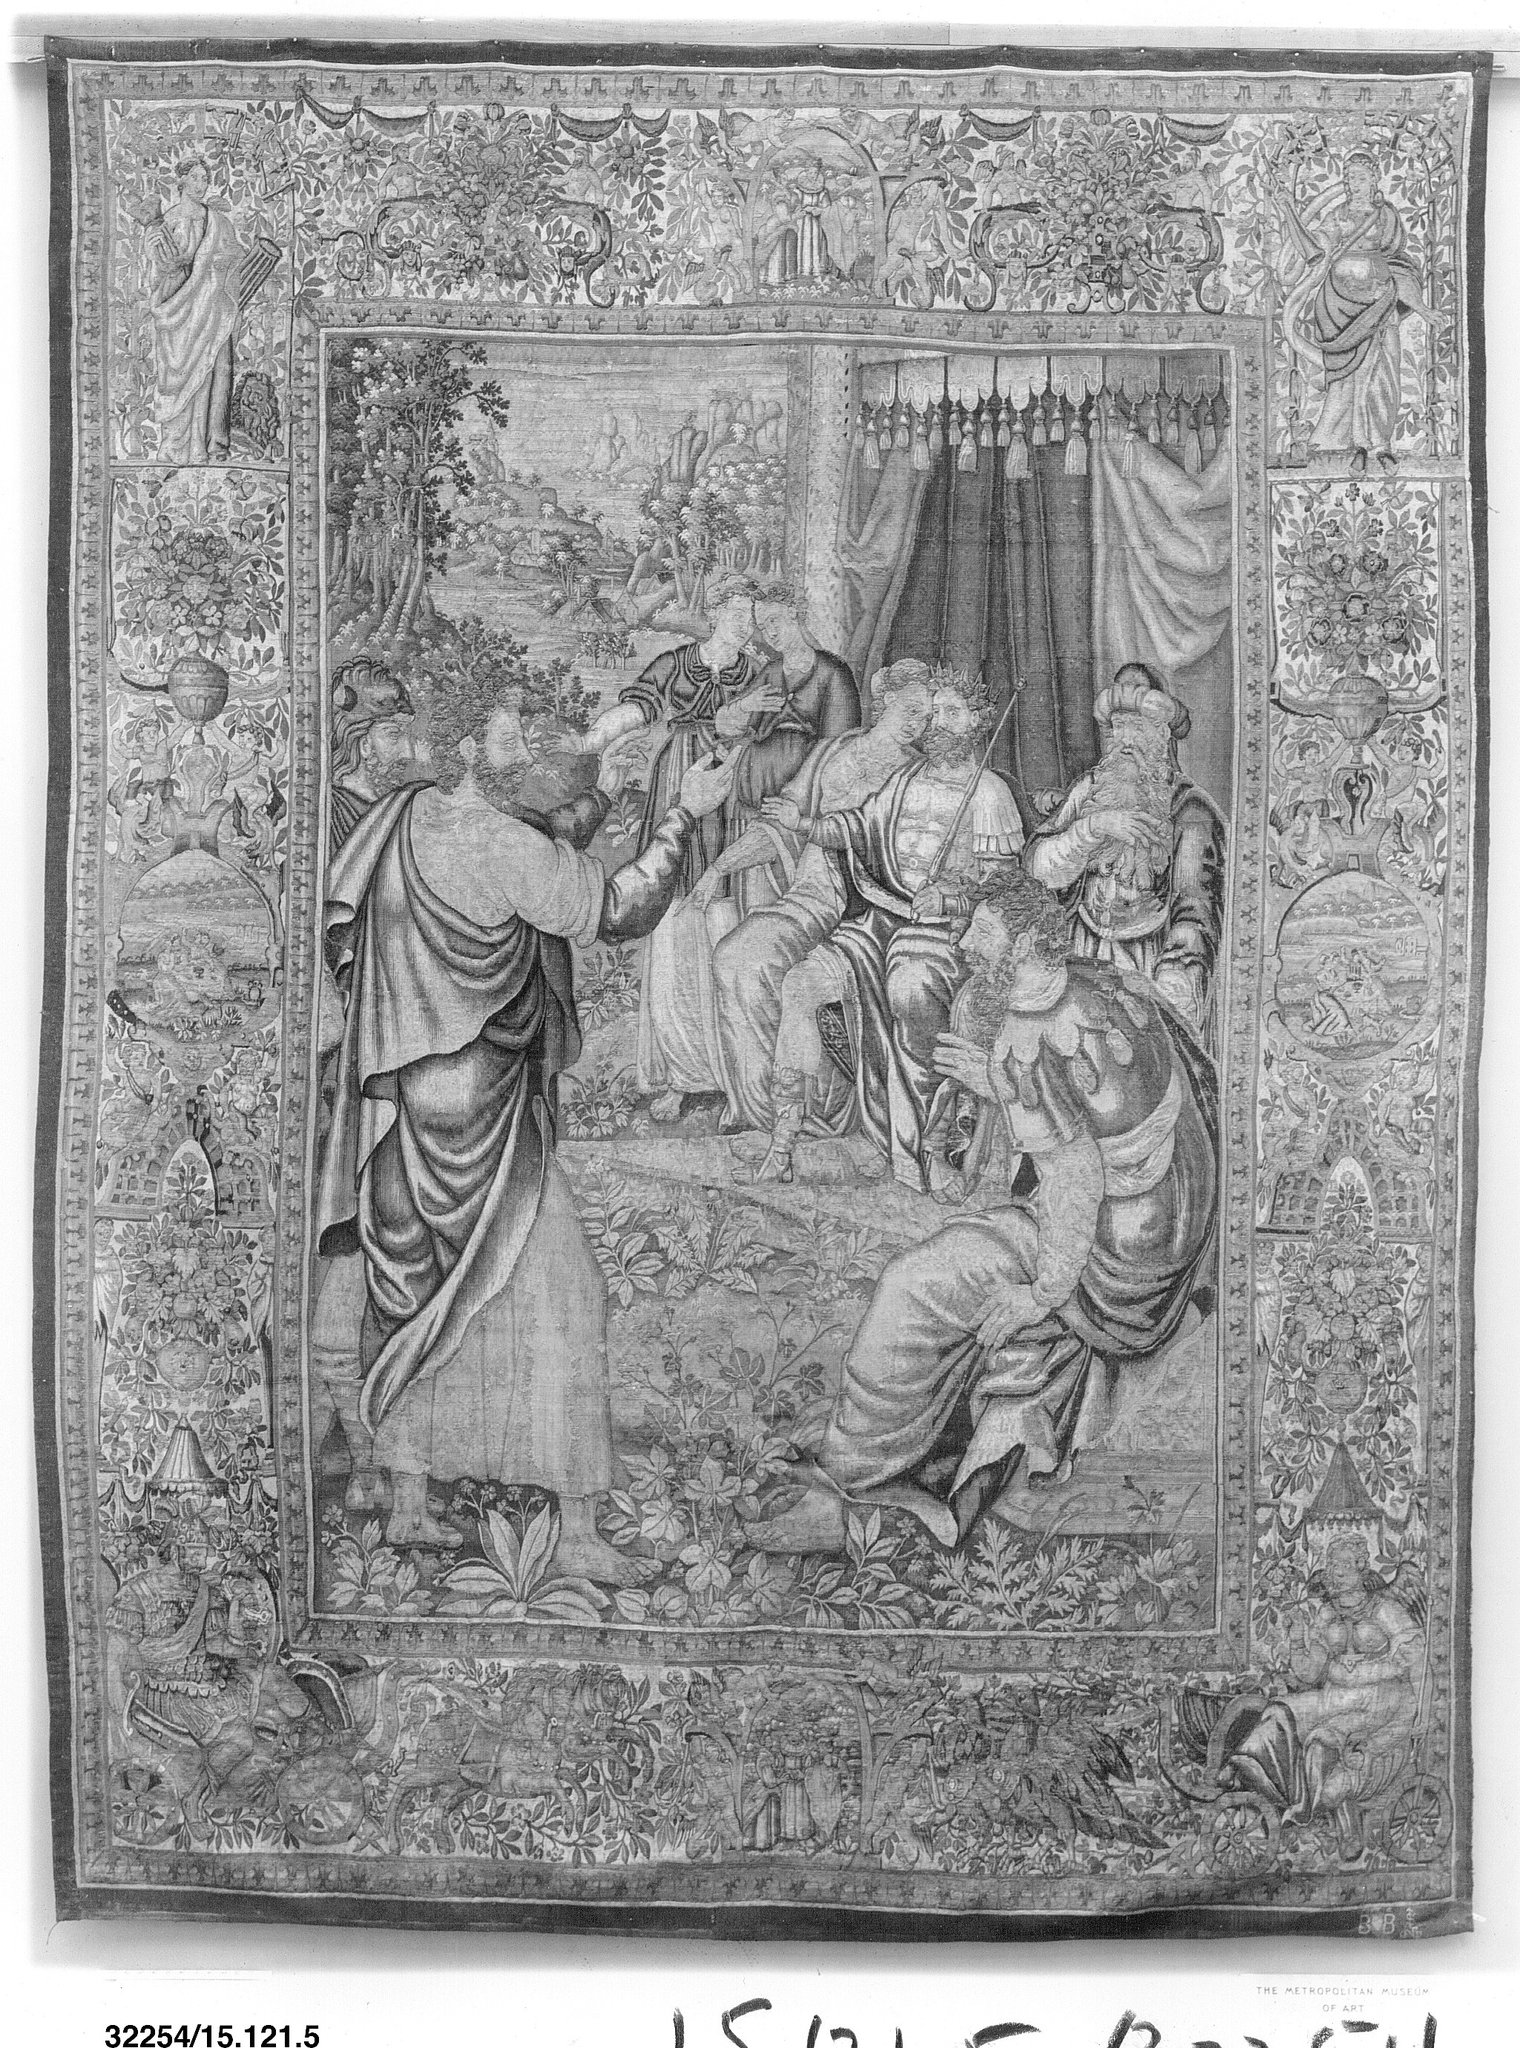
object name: tapestry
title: Paul before Agrippa from a set of Scenes from the Life of Saint Paul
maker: raphael (raffaello sanzio or santi)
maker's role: designer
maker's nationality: italian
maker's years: 1483-1520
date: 1600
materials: silk, wool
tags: tents,men,women,saint paul